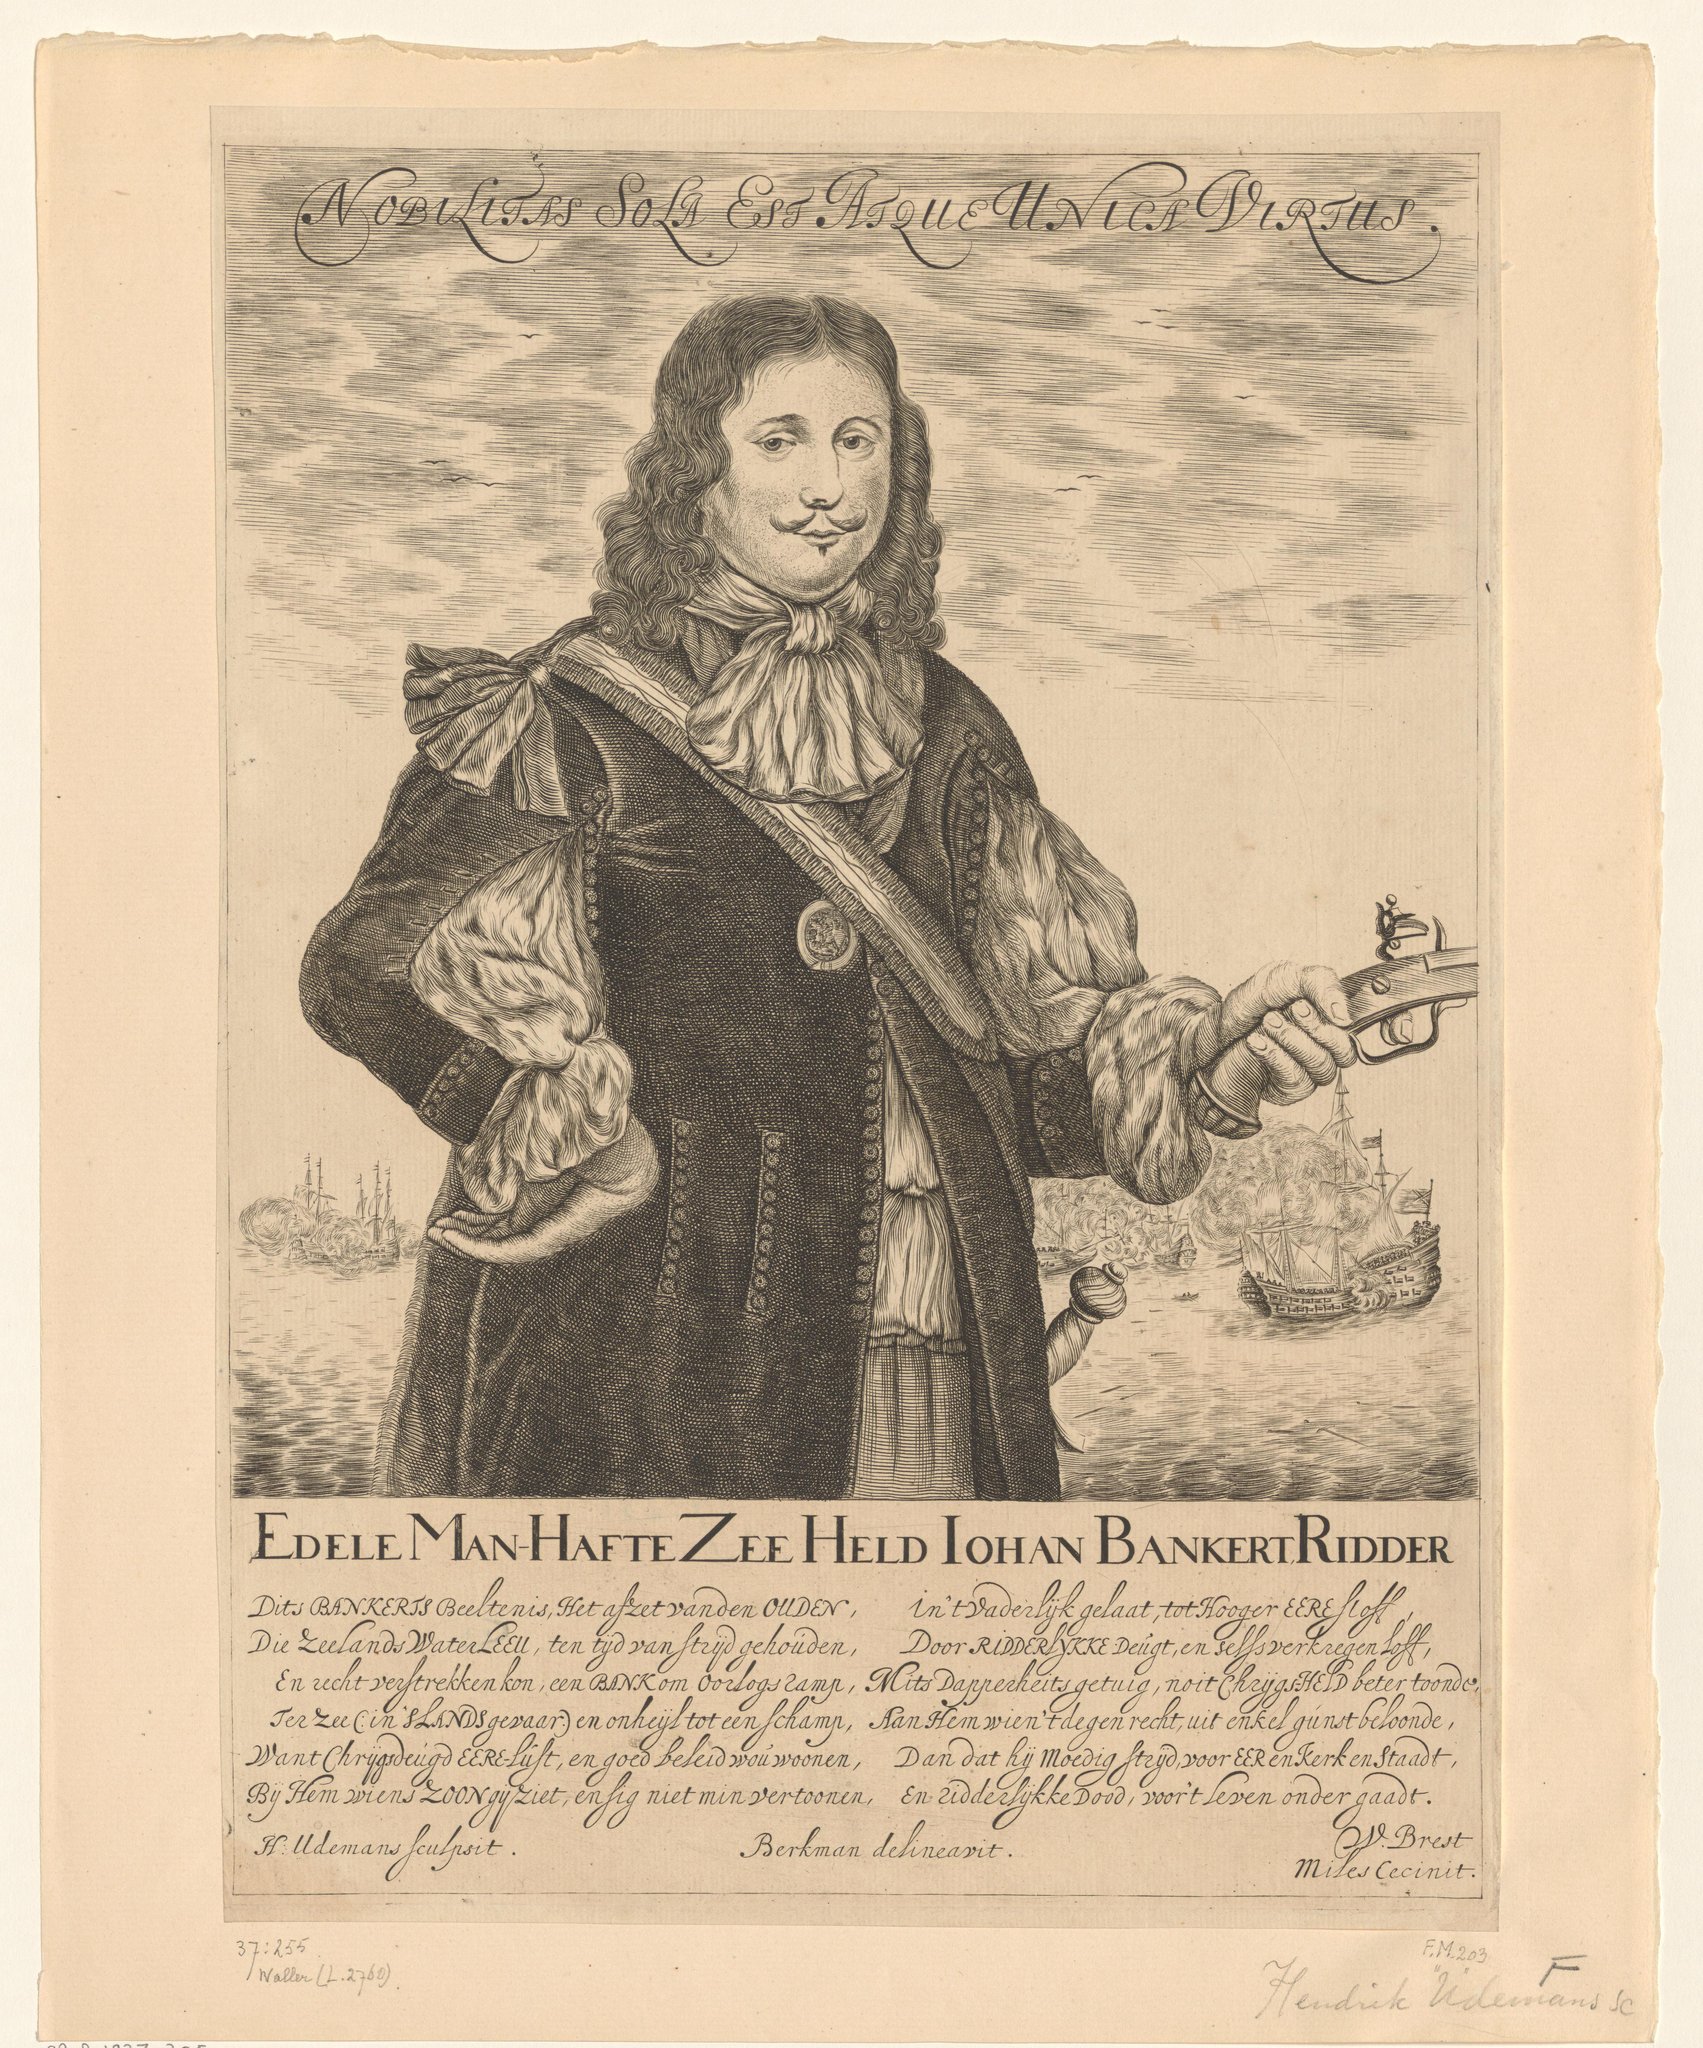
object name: print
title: Portret van Joost van Trappen Banckers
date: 1647-1649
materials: paper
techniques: engraving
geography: zeeland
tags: flushing, battle (+ naval force), historical persons, firearms, commander-in-chief, admiral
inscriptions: collector's mark: Lugt 2228